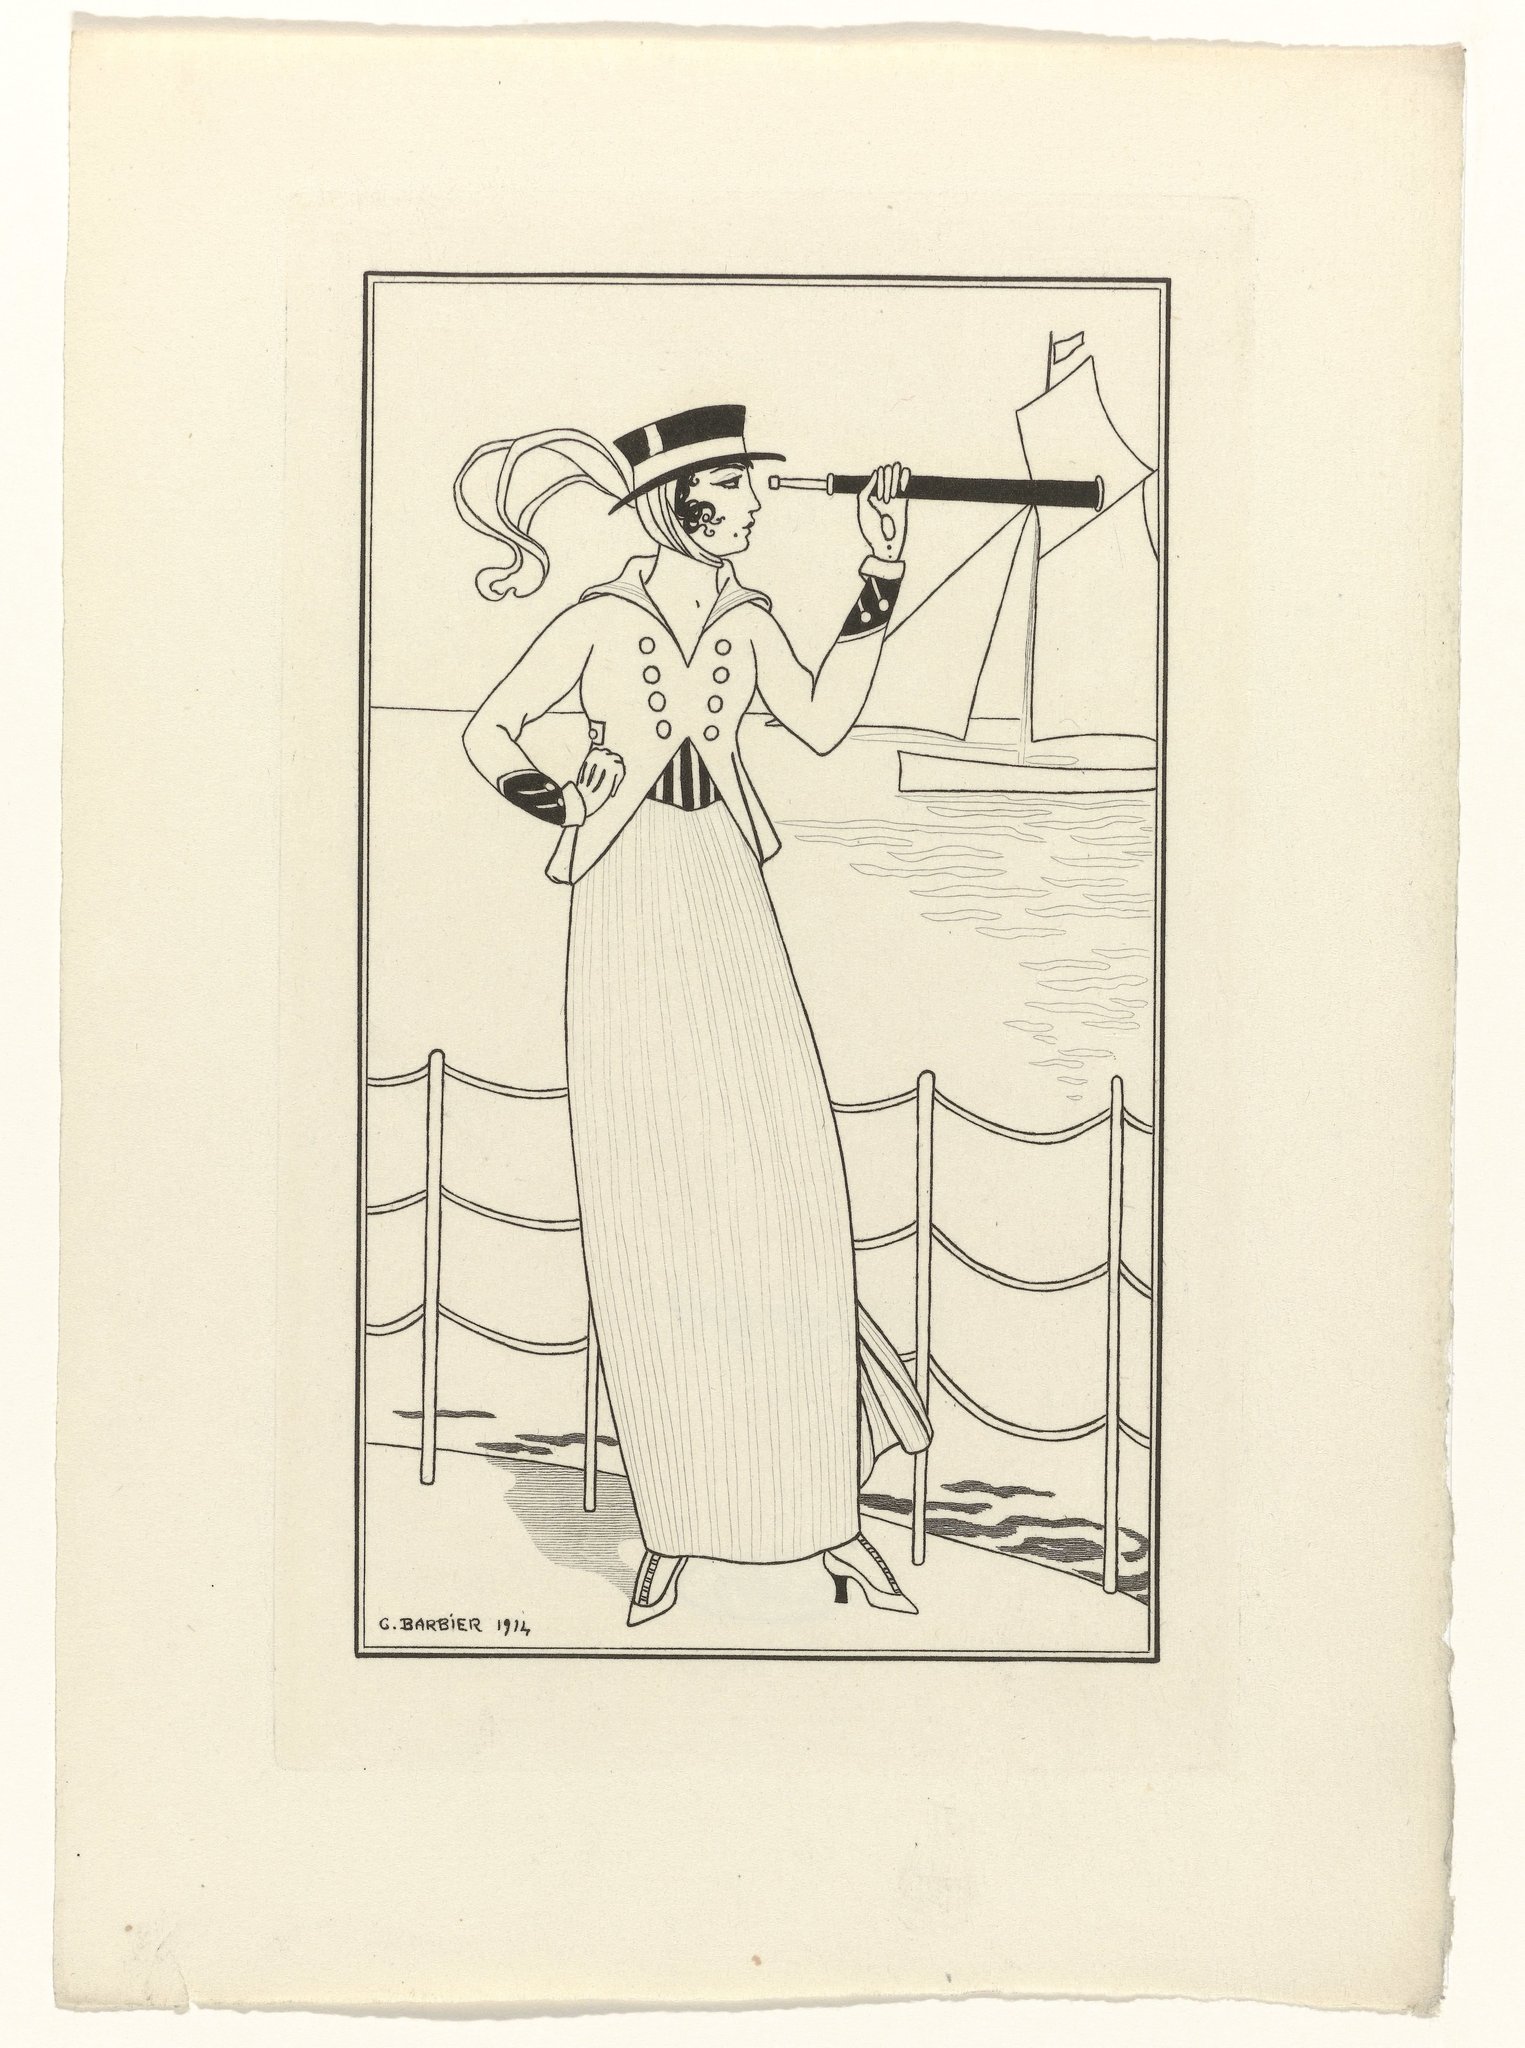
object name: fashion print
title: Journal des Dames et des Modes, Costumes Parisiens, 1914, No. 164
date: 1914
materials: paper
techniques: engraving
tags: head-gear: hat (+ leather used for clothes), sailing (sport) (+ equipment, outfit (sports, games, etc.)), coat (+ women's clothes), fashion plates, head-gear: hat (+ women's clothes), skirt (+ women's clothes), binoculars, spy-glass, etc.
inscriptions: date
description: Vrouw in en kostuum voor een pleziervaart: jasje van laken op een rok van gestreept doek. Hoed van leer. Verrekijker in de hand. Op de achtergrond een zeilschip. Proefdruk van een prent uit het modetijdschrift Journal des Dames et des Modes (1912-1914).